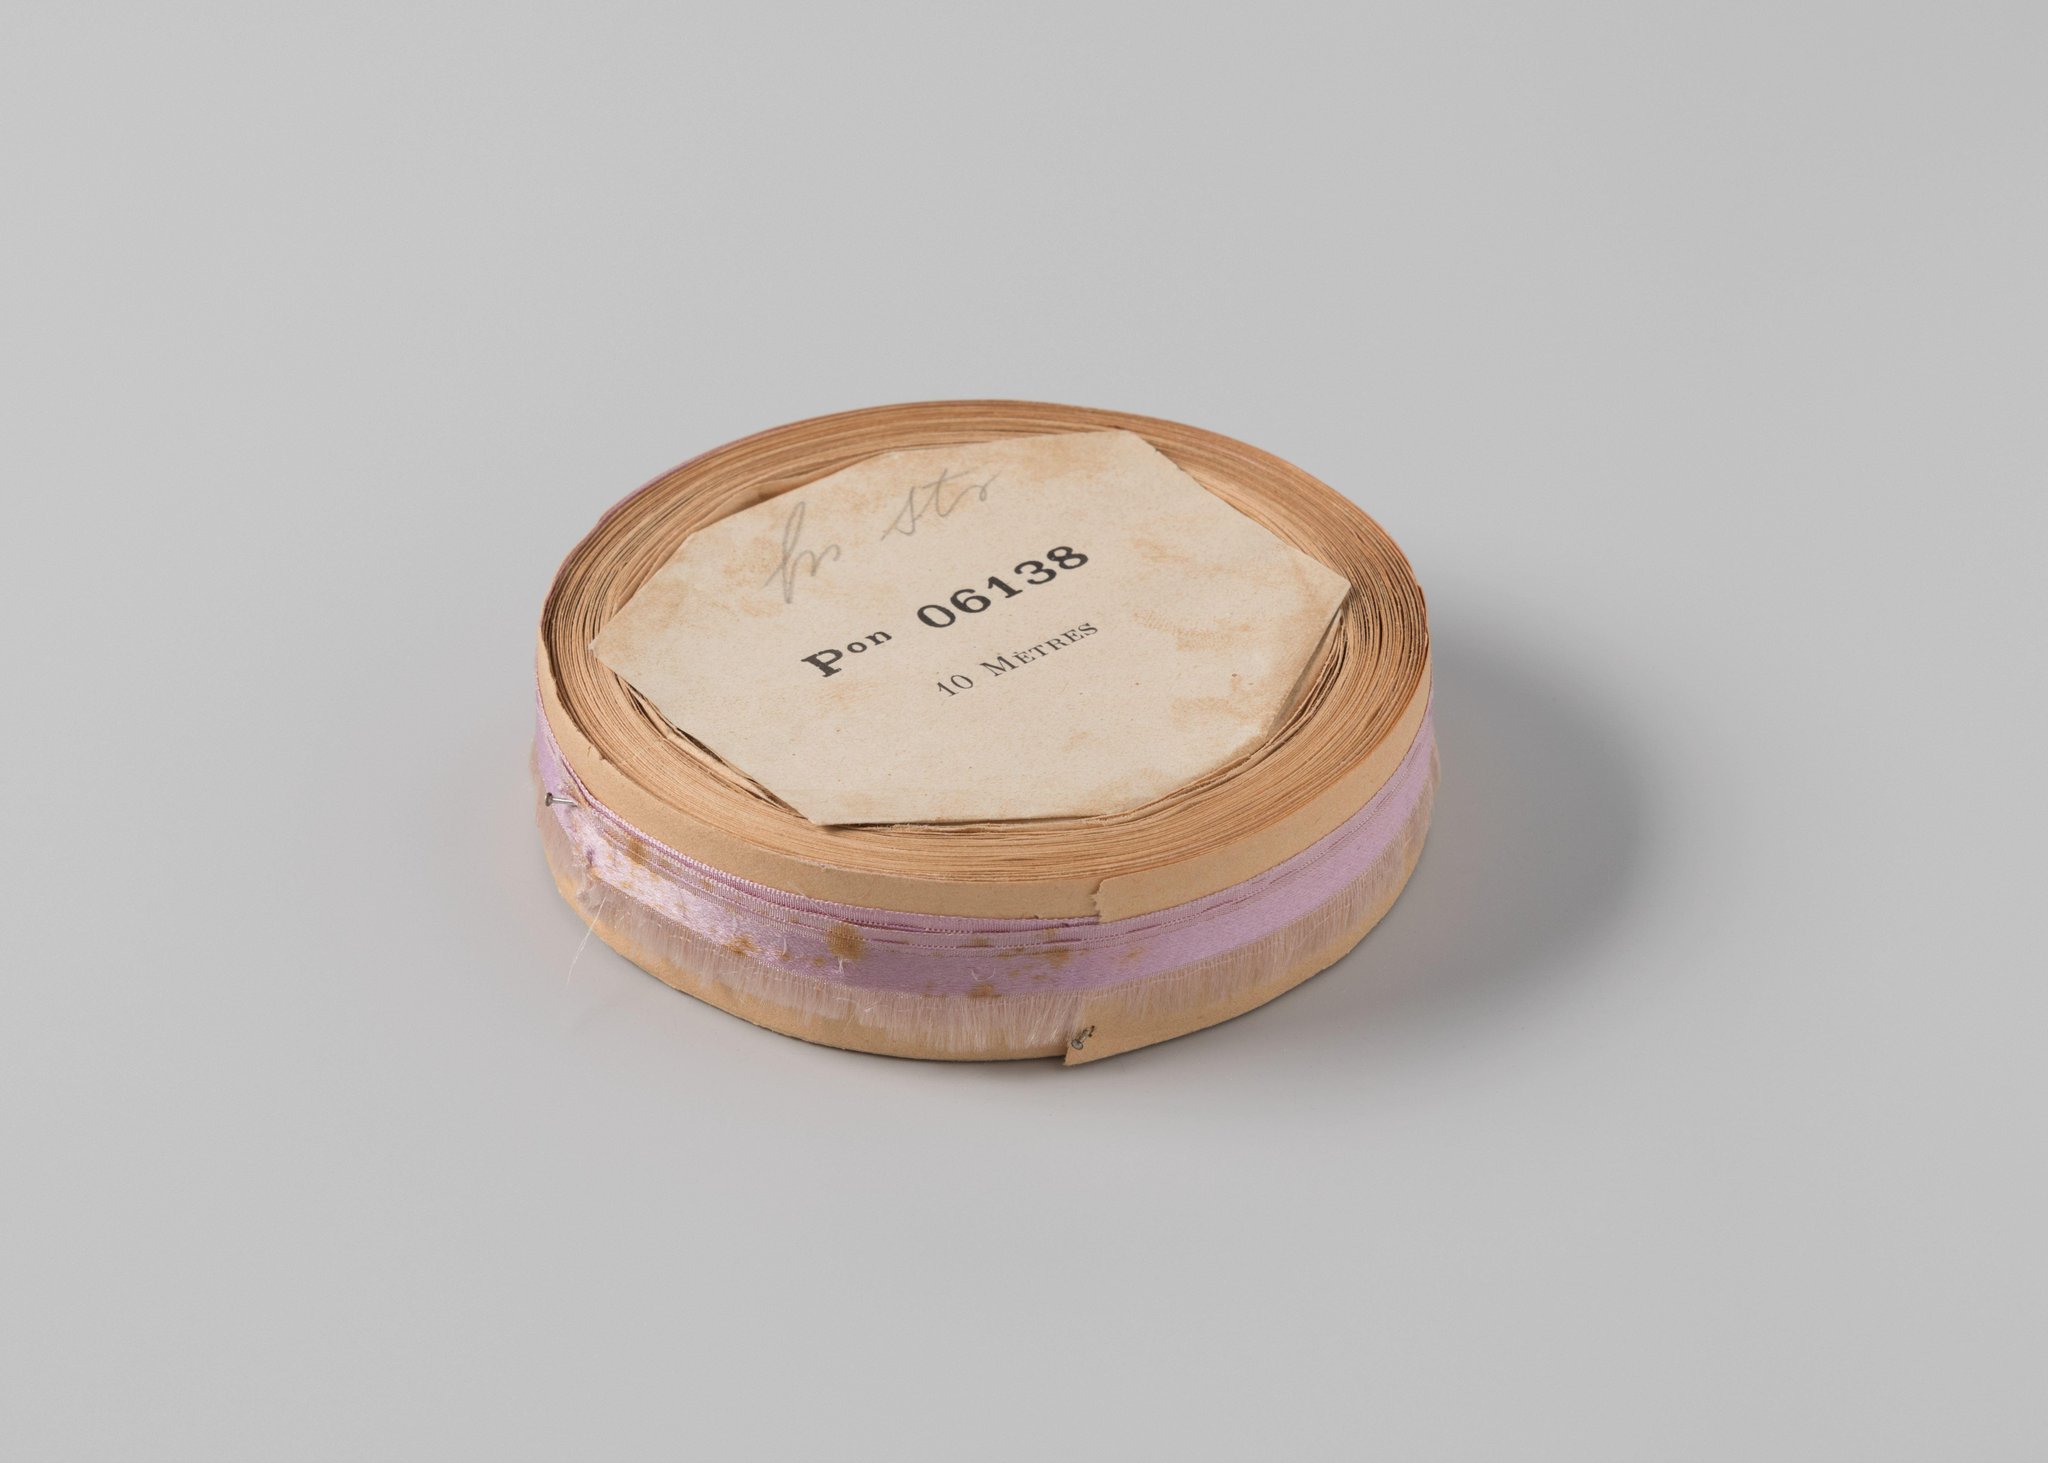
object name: ribbon material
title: Rol met lila satijnlint met één gerafelde zijde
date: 1935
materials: cardboard, paper, textile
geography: nijmegen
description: Rol met lila satijnlint met één gerafelde zijde.